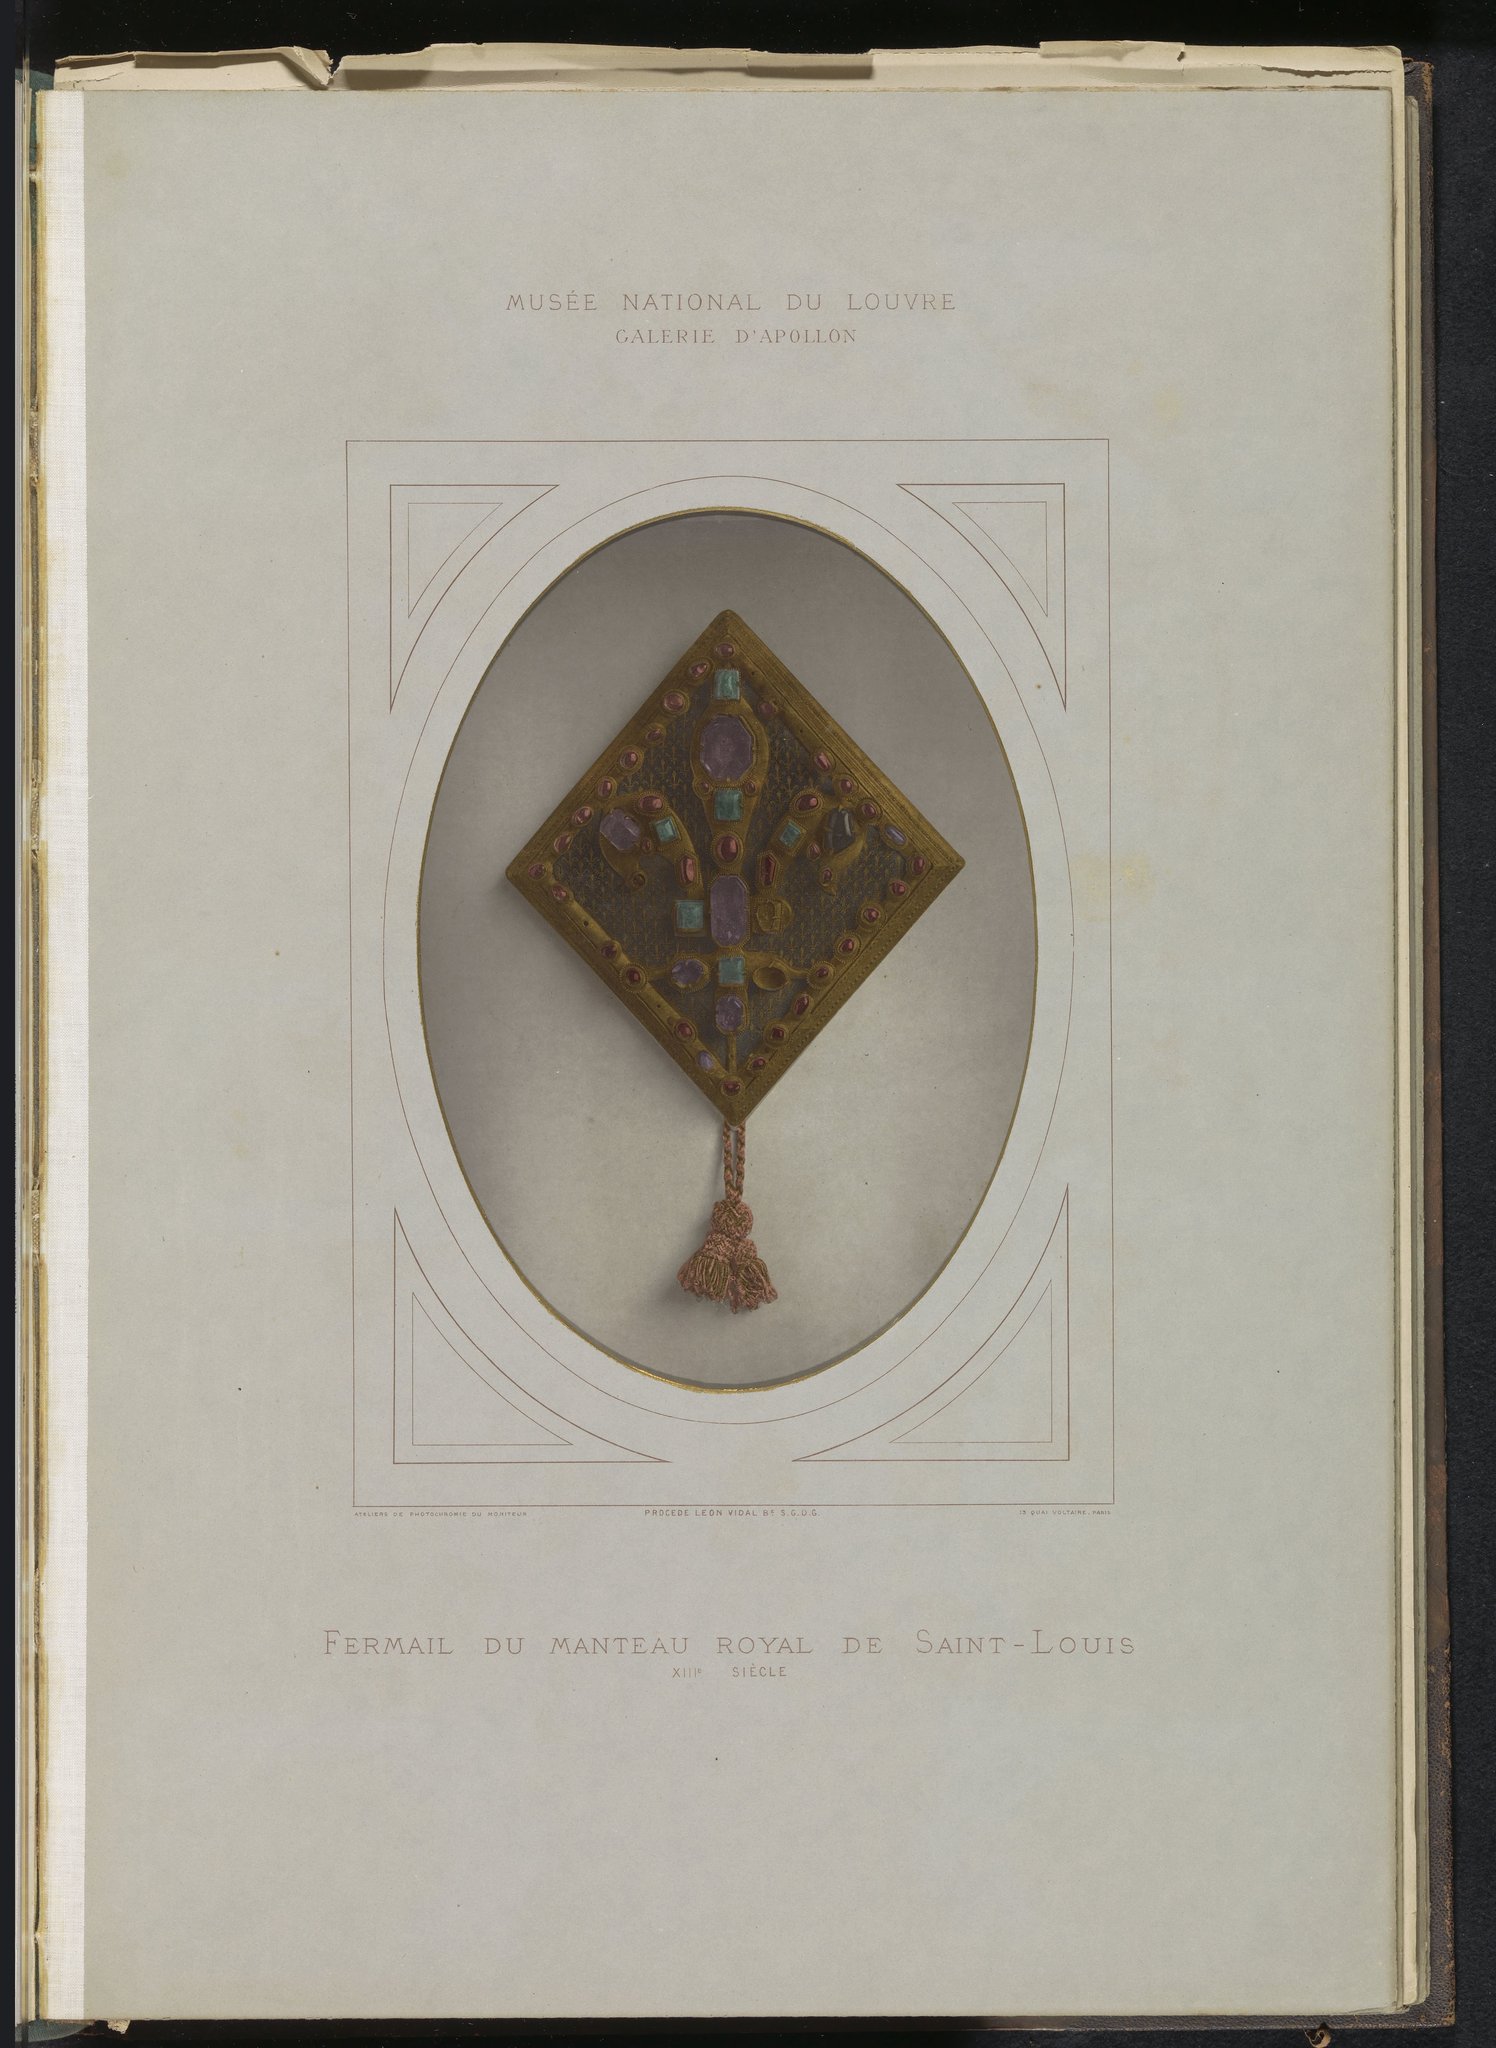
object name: photomechanical print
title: Musée National du Louvre Galerie d'Apollon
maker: léon vidal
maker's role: fotograaf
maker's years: 1833-1906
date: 1876-1883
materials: paper, photographic process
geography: paris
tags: fibula, safety pin, coat, cape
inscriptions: inscription: ‘XIIIe siècle’, inscription: ‘ateliers de photochromie du moniteur’